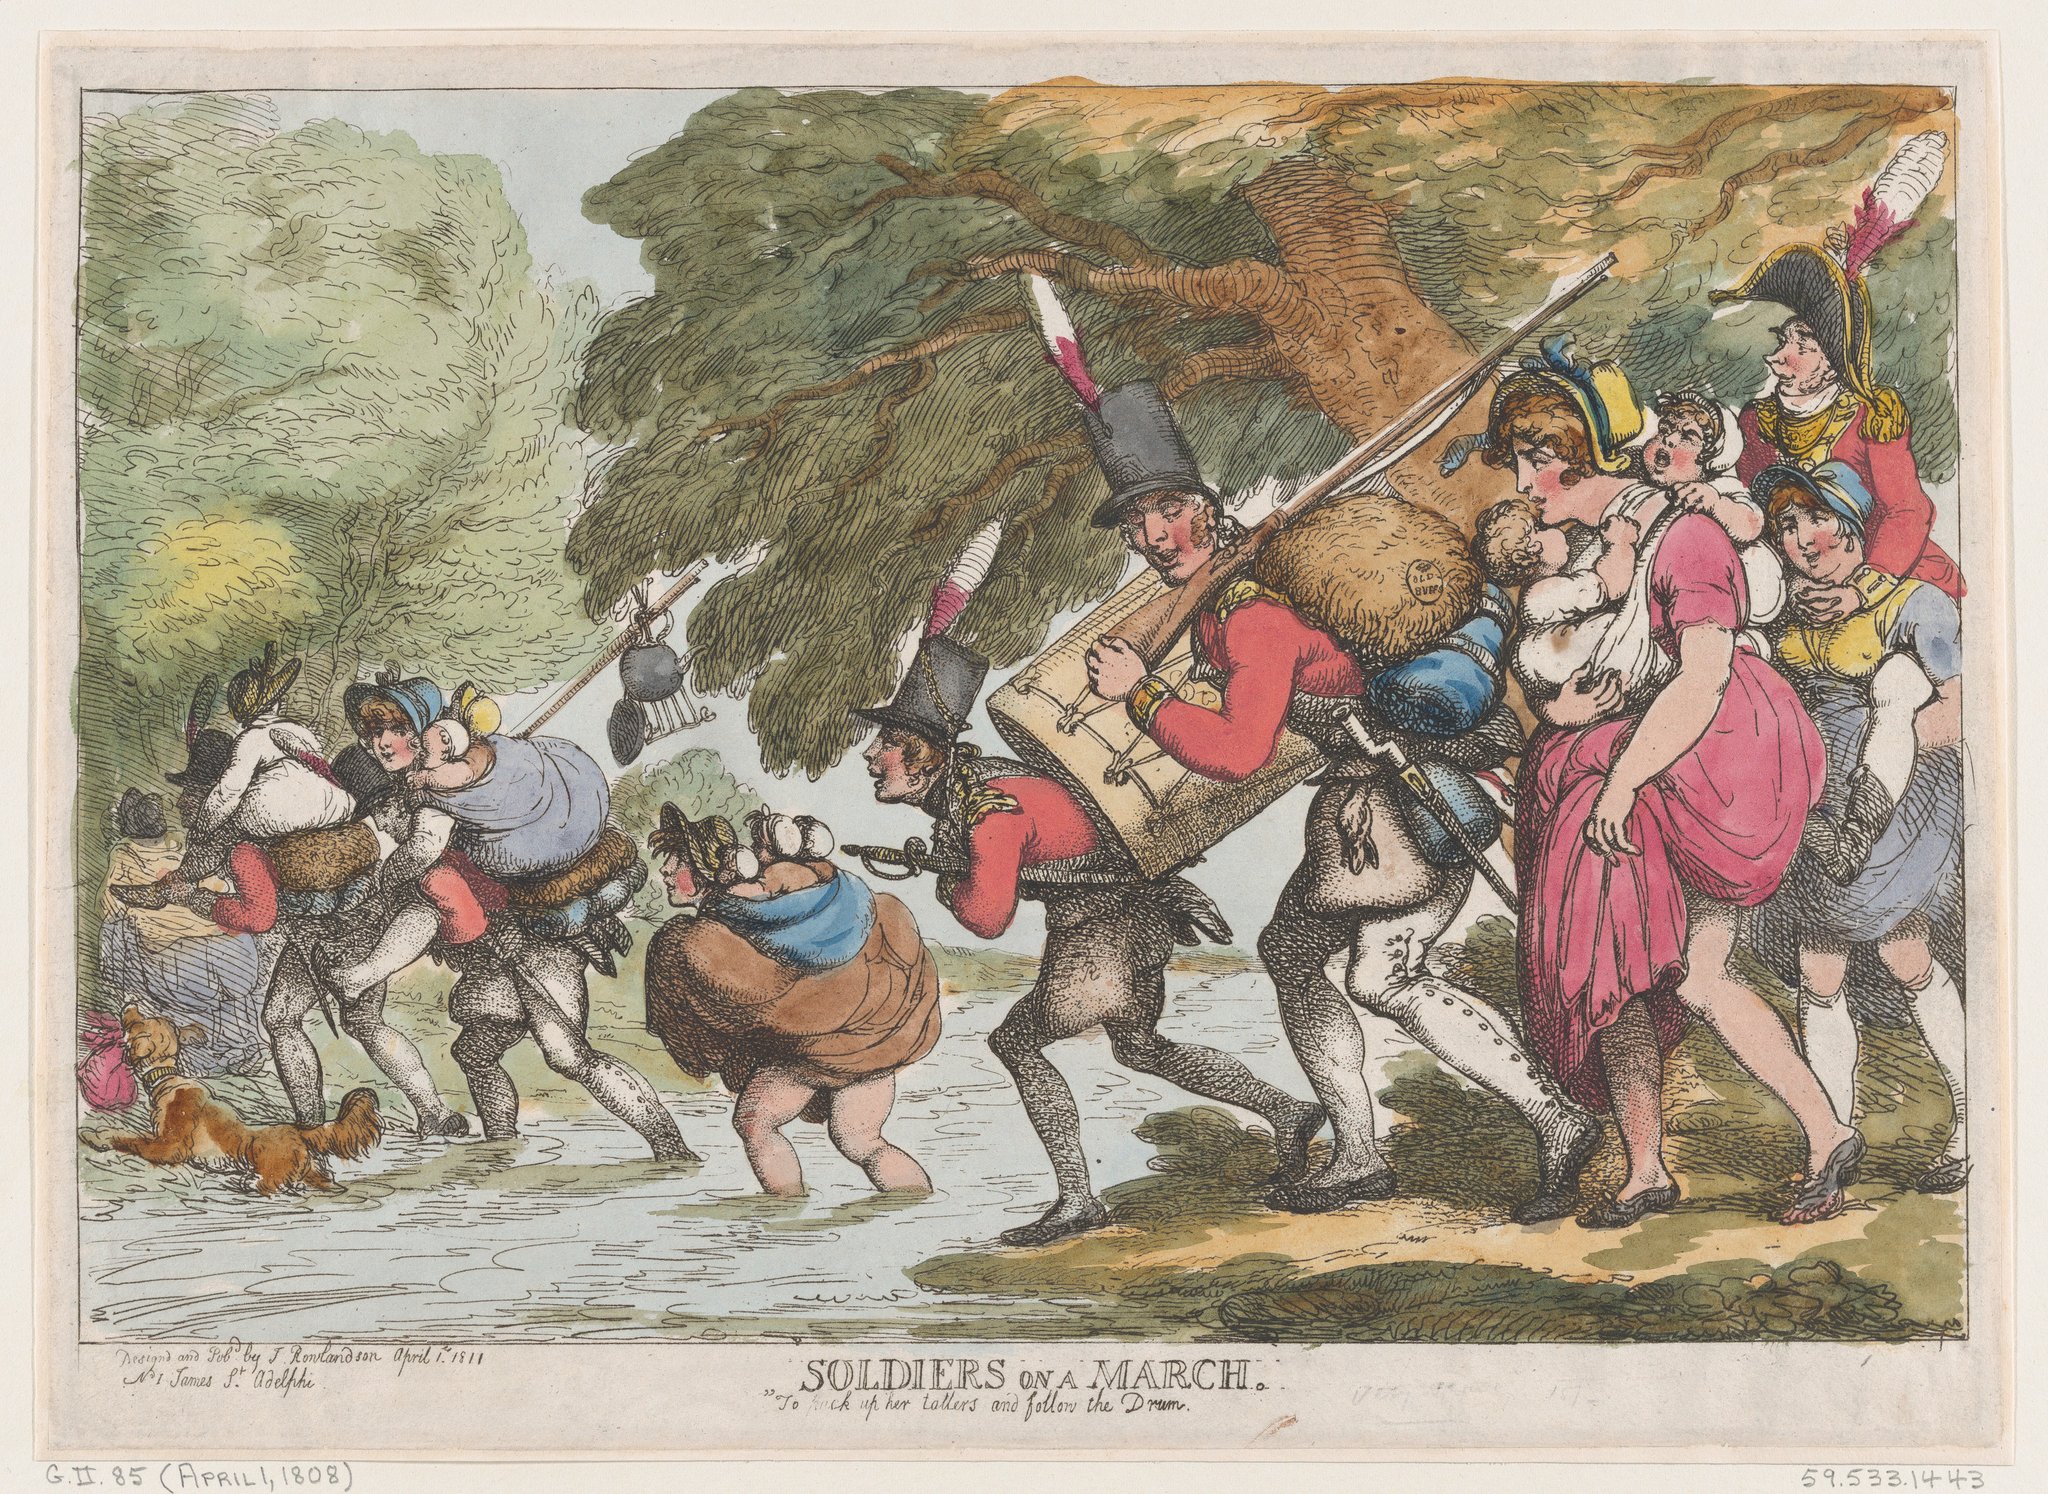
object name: print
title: Soldiers on a March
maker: thomas rowlandson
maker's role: artist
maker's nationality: british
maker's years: 1757-1827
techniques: etching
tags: satire,soldiers,men,women